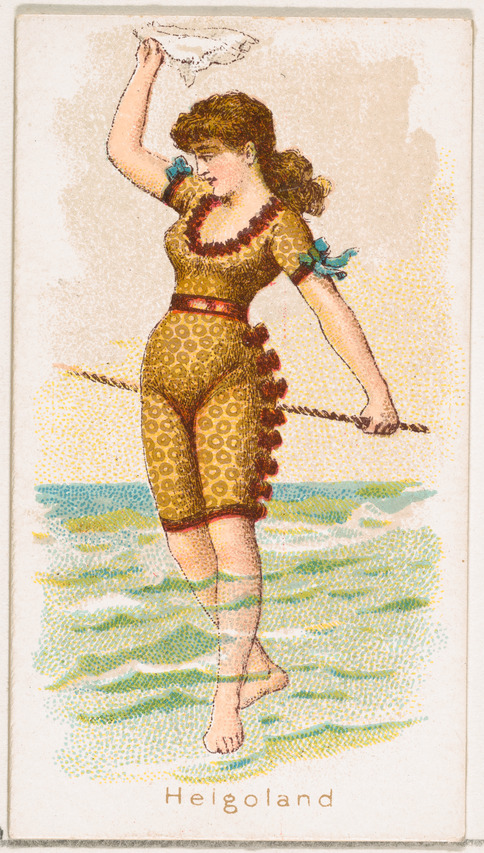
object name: print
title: Helgoland, from the Fancy Bathers series (N187) issued by Wm. S. Kimball & Co.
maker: william s. kimball & company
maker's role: publisher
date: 1889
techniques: color lithograph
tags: profiles,women